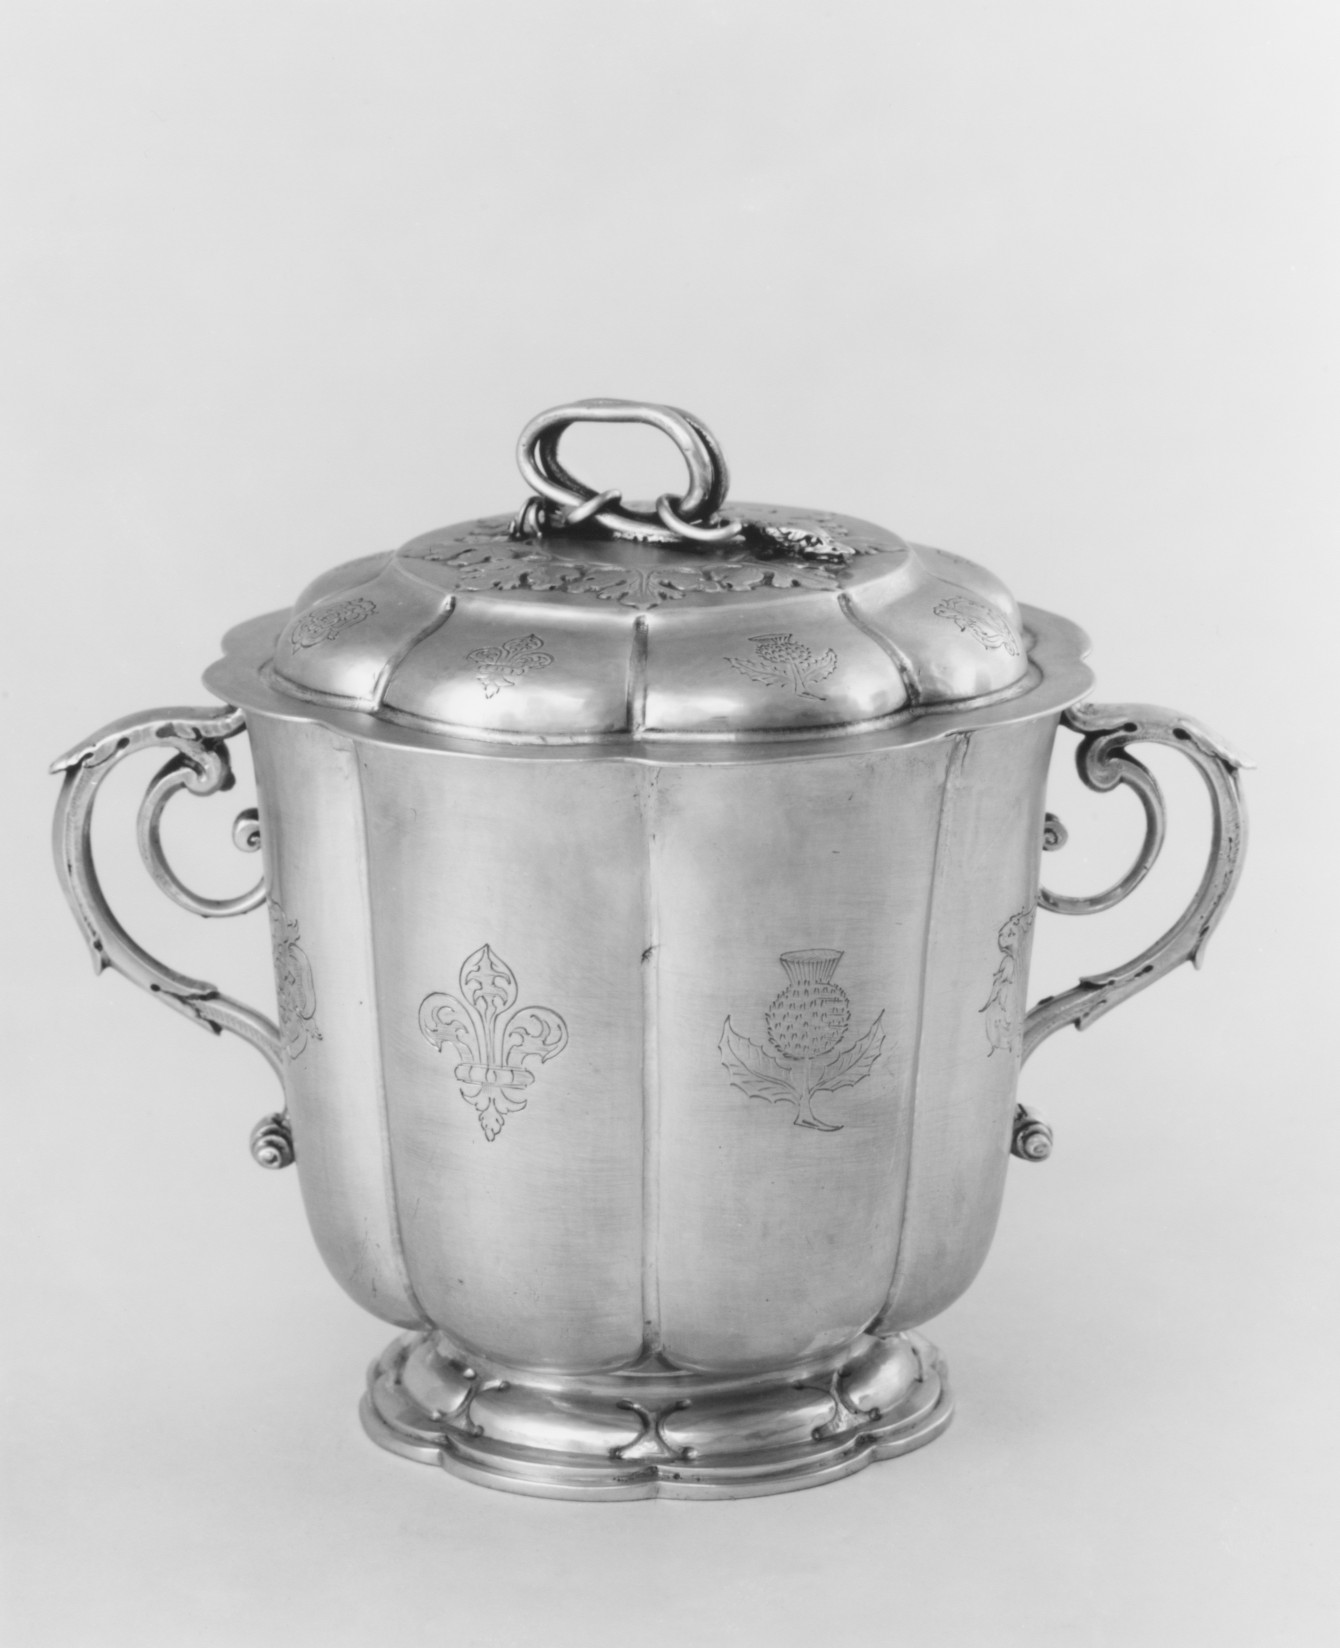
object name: cup with cover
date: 1664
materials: silver